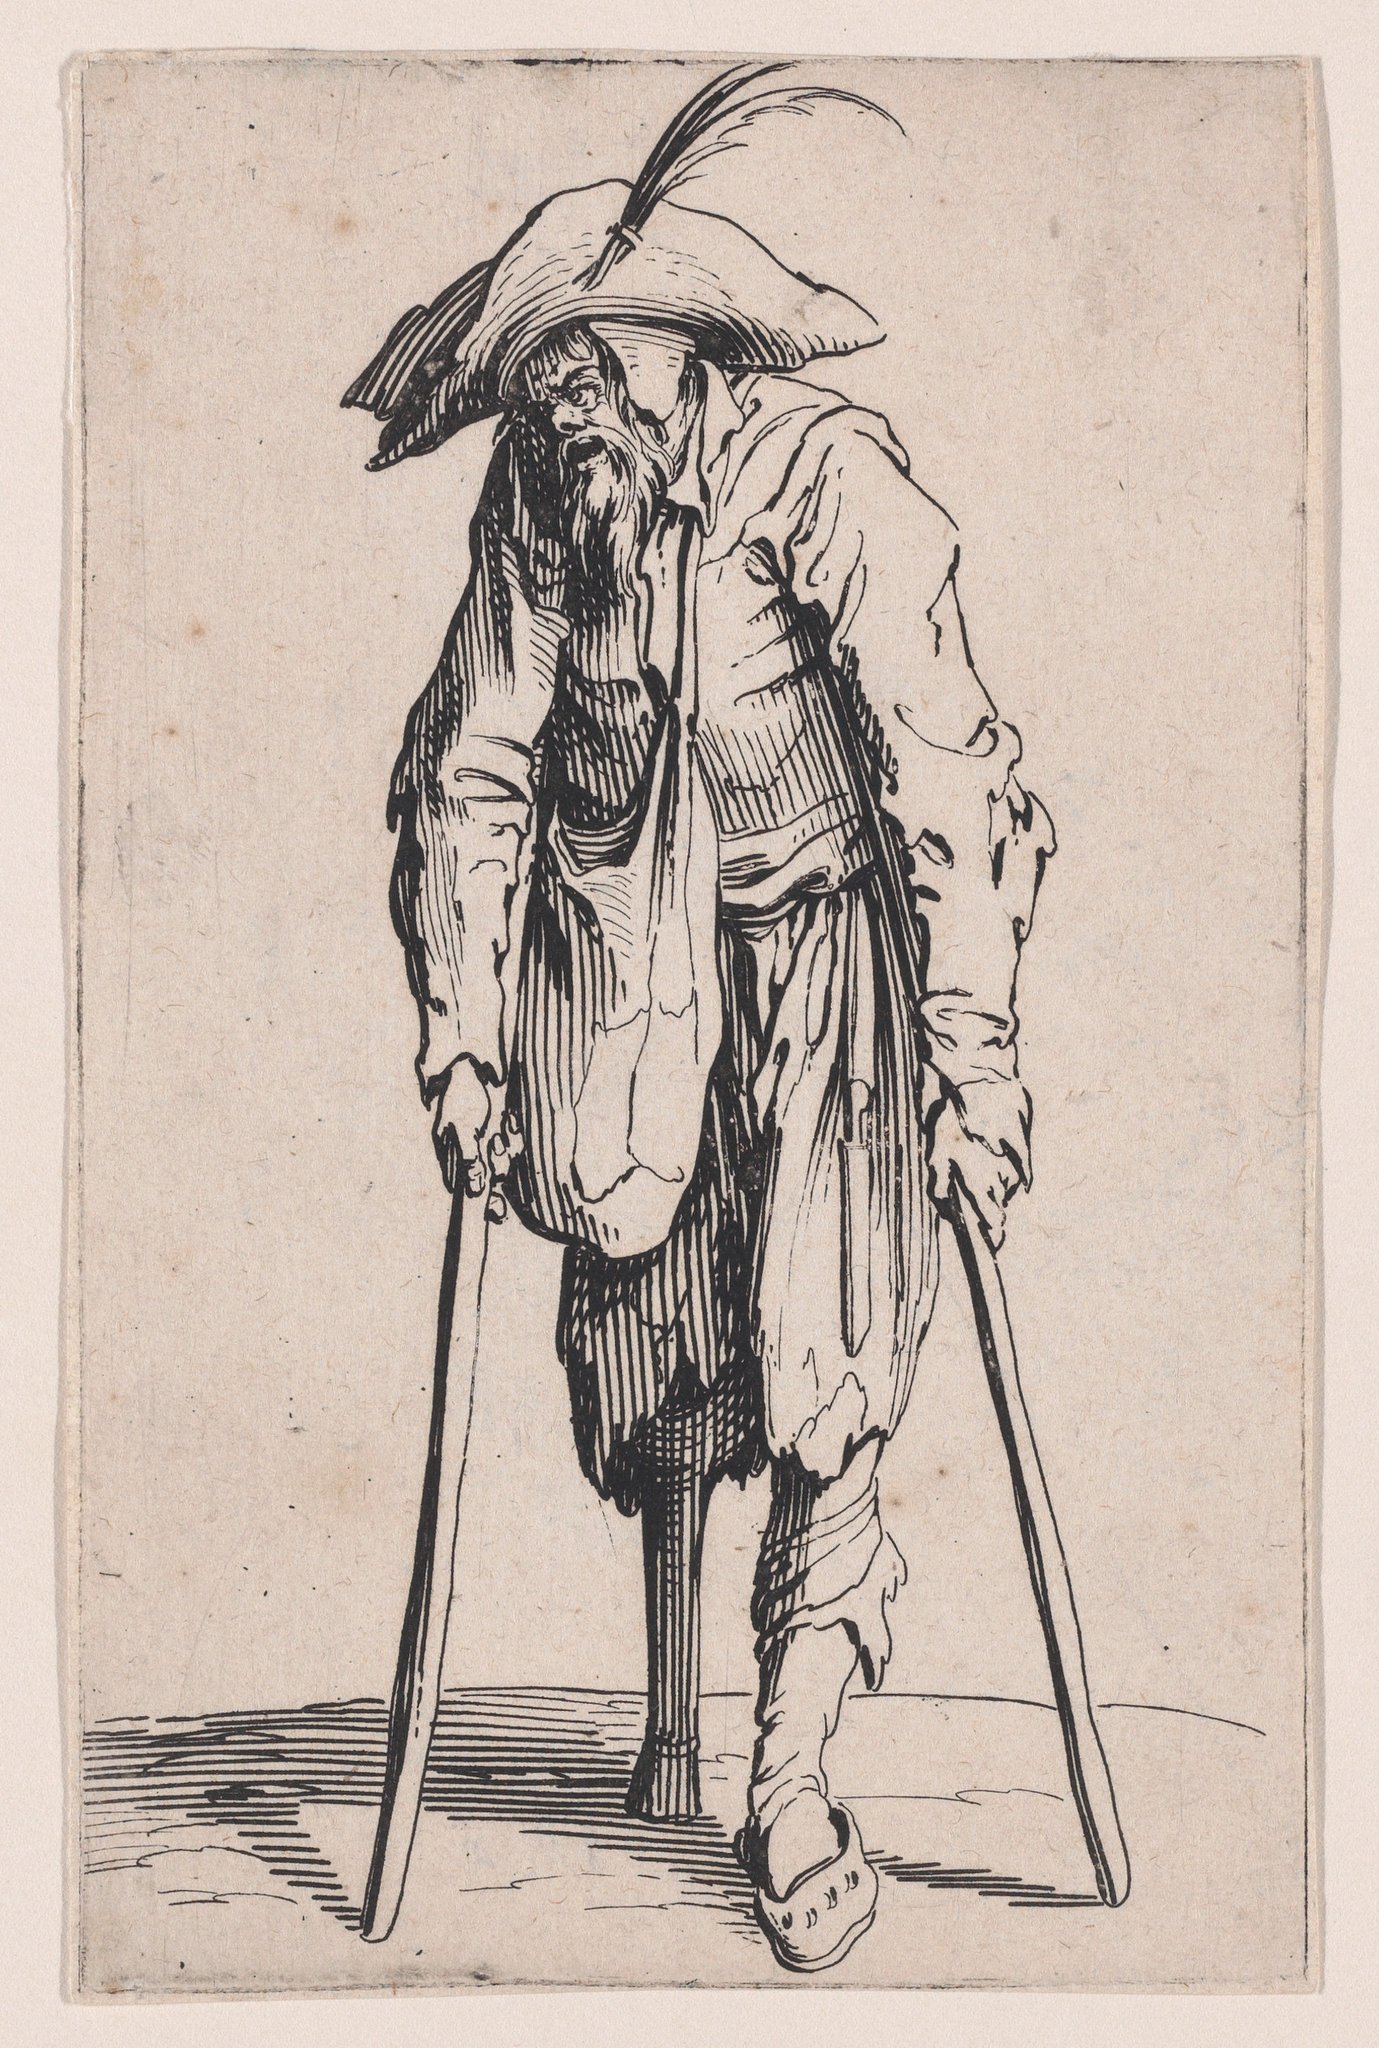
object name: print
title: Le Mendiant a la Jambe de Bois (The Beggar with the Wooden Leg), from "Les Gueux suite appelée aussi Les Mendiants, Les Baroni, ou Les Barons" (The Beggars, also called the Barons)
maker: jacques callot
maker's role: artist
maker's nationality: french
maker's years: 1592-1635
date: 1623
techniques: etching